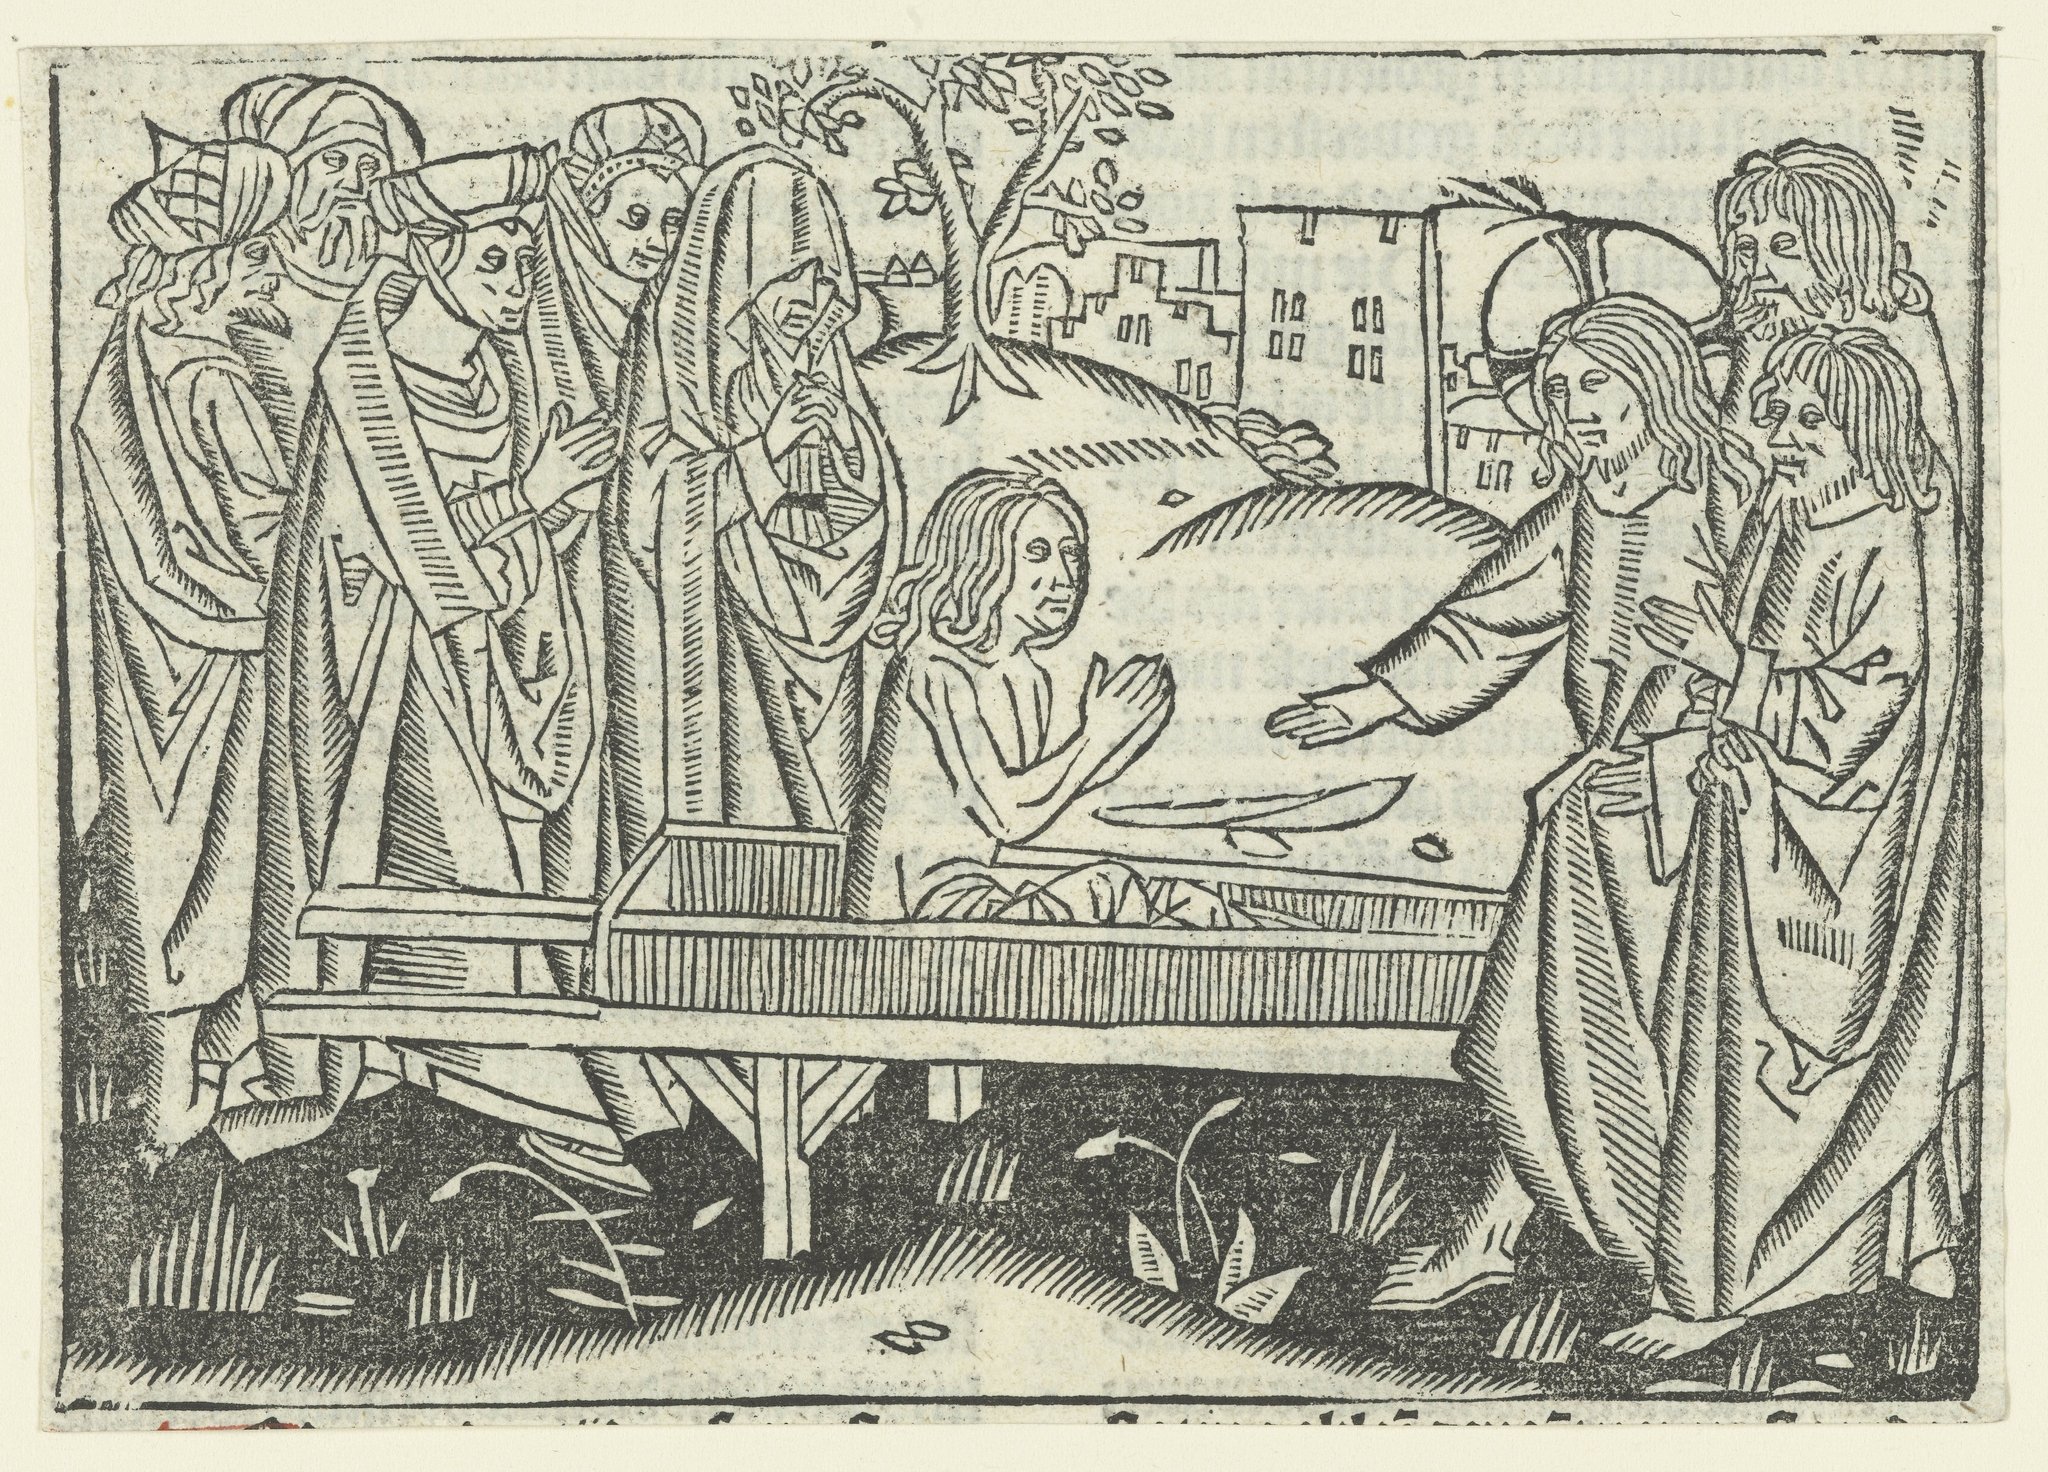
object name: book illustration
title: De opwekking van de zoon van de weduwe te Naïn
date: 1480-1500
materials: paper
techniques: woodcut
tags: christ touches the bier of the son of the widow of nain: the young man sits up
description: Eén blad van 113 uit Ludolphus de Saxonia, "Dit es dleué ons liefs heeren ihesu christi". Anonieme Nederlandse vertaling. Uitgegeven door Henrick Eckert van Homberch te Antwerpen in 1503. Botke, K. Deze 113 houtsneden, die meestal reeds in vroege Nederlandse boeken gebruikt zijn, worden toegeschreven aan de tweede Meester van Delft, de Meester van de Delbecq-Schreiber-passie en de Meester van de Virgo inter Virgines. In Conway (1884) en in "De gulden passer"(1951) zijn ook eerdere versies opgenomen. Botke, K.